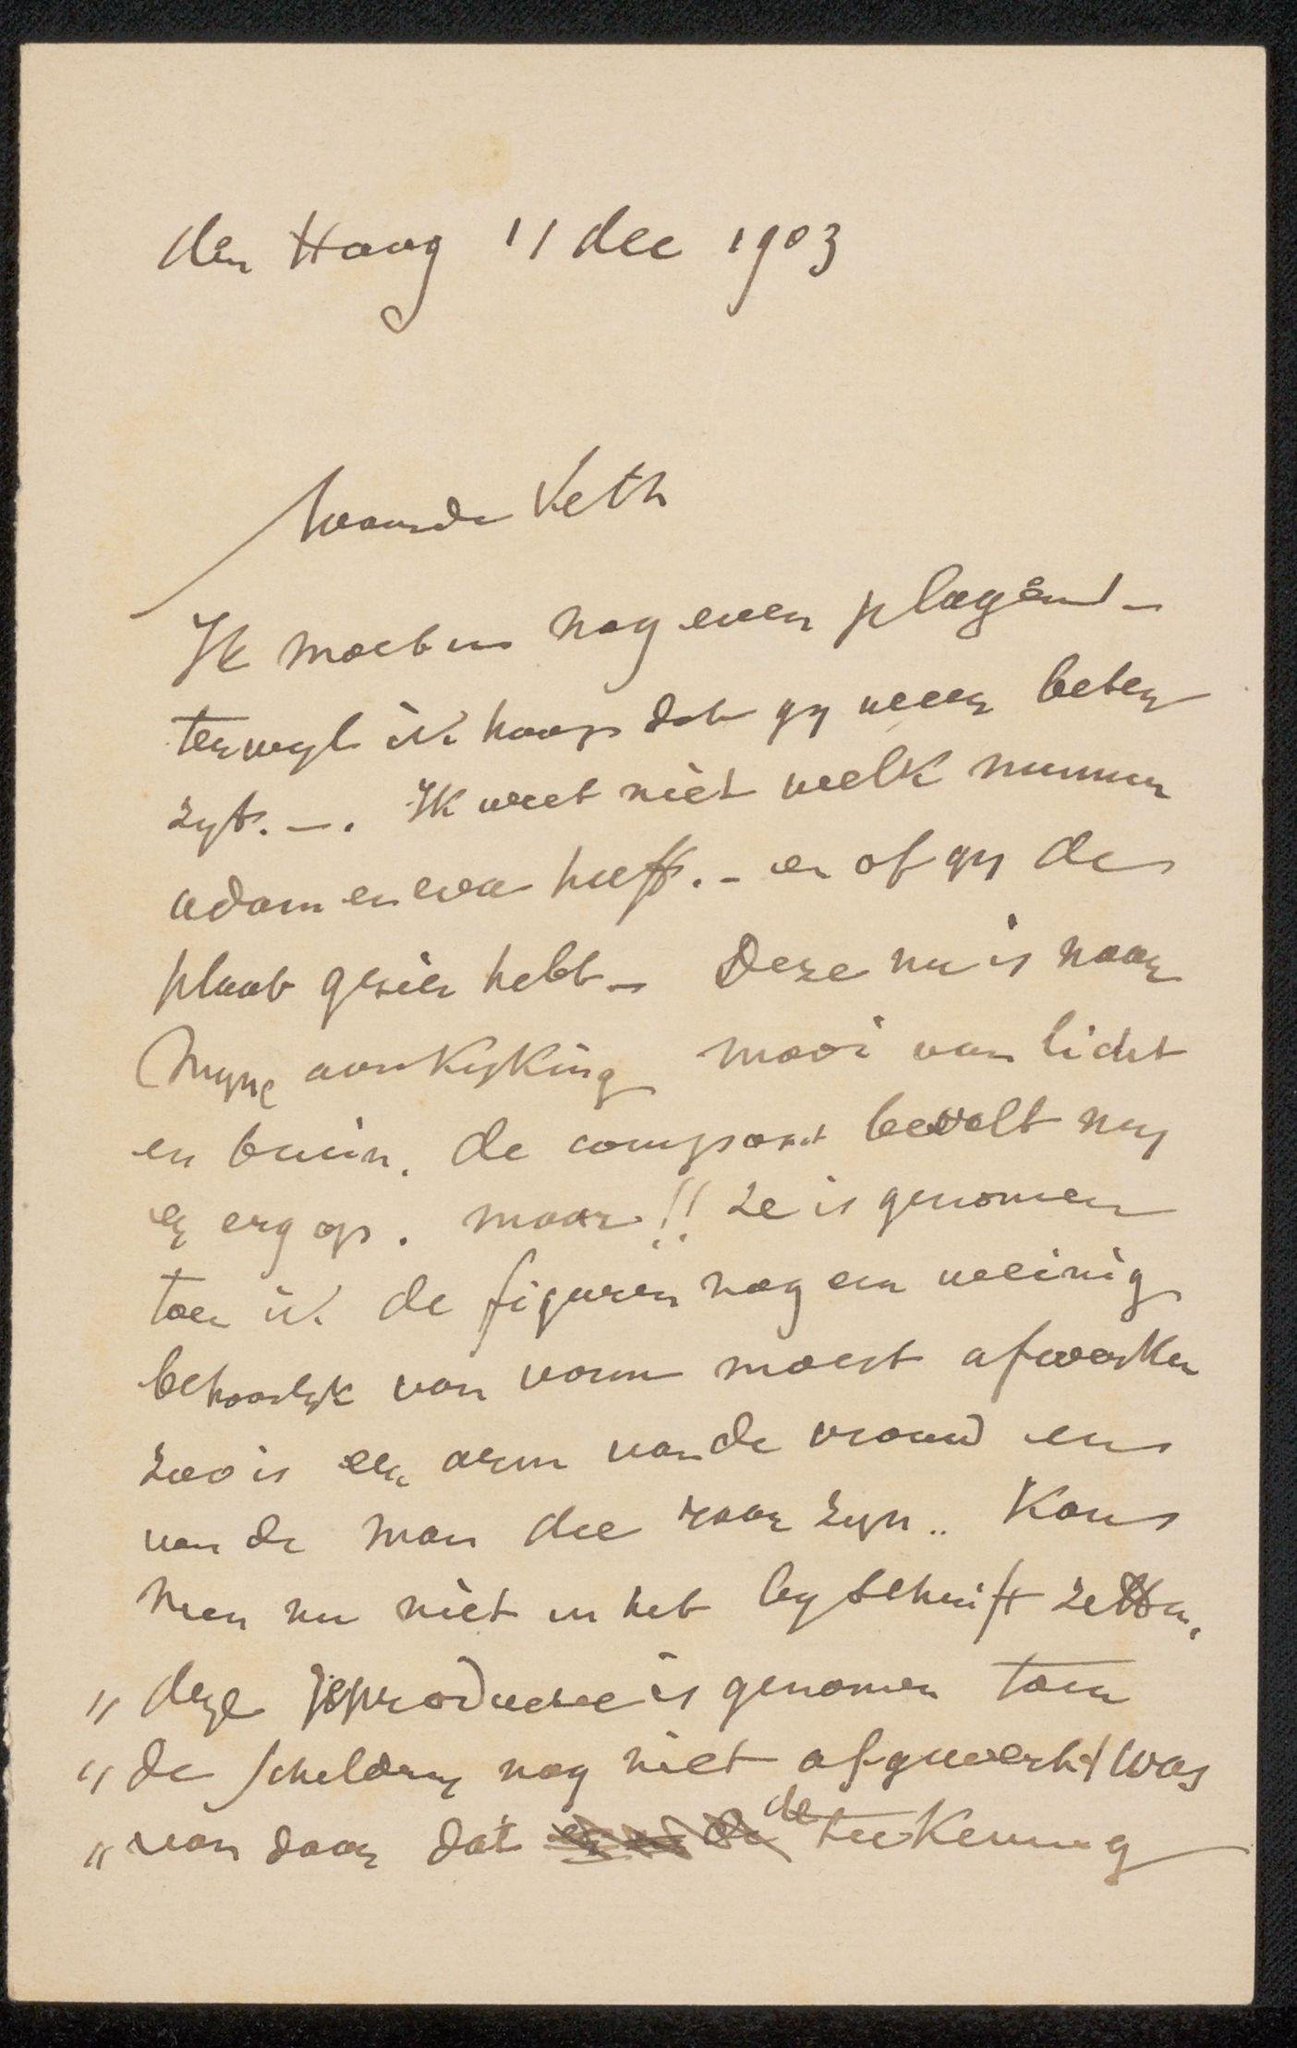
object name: letter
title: Brief aan Jan Veth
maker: jozef israëls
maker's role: draughtsman, painter, print maker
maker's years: 1824-1911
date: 1903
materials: ink, paper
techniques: pen, writing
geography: the hague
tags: dordrecht, amsterdam, designer, jan veth, printed matter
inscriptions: collector's mark: ‘RPK’, watermark